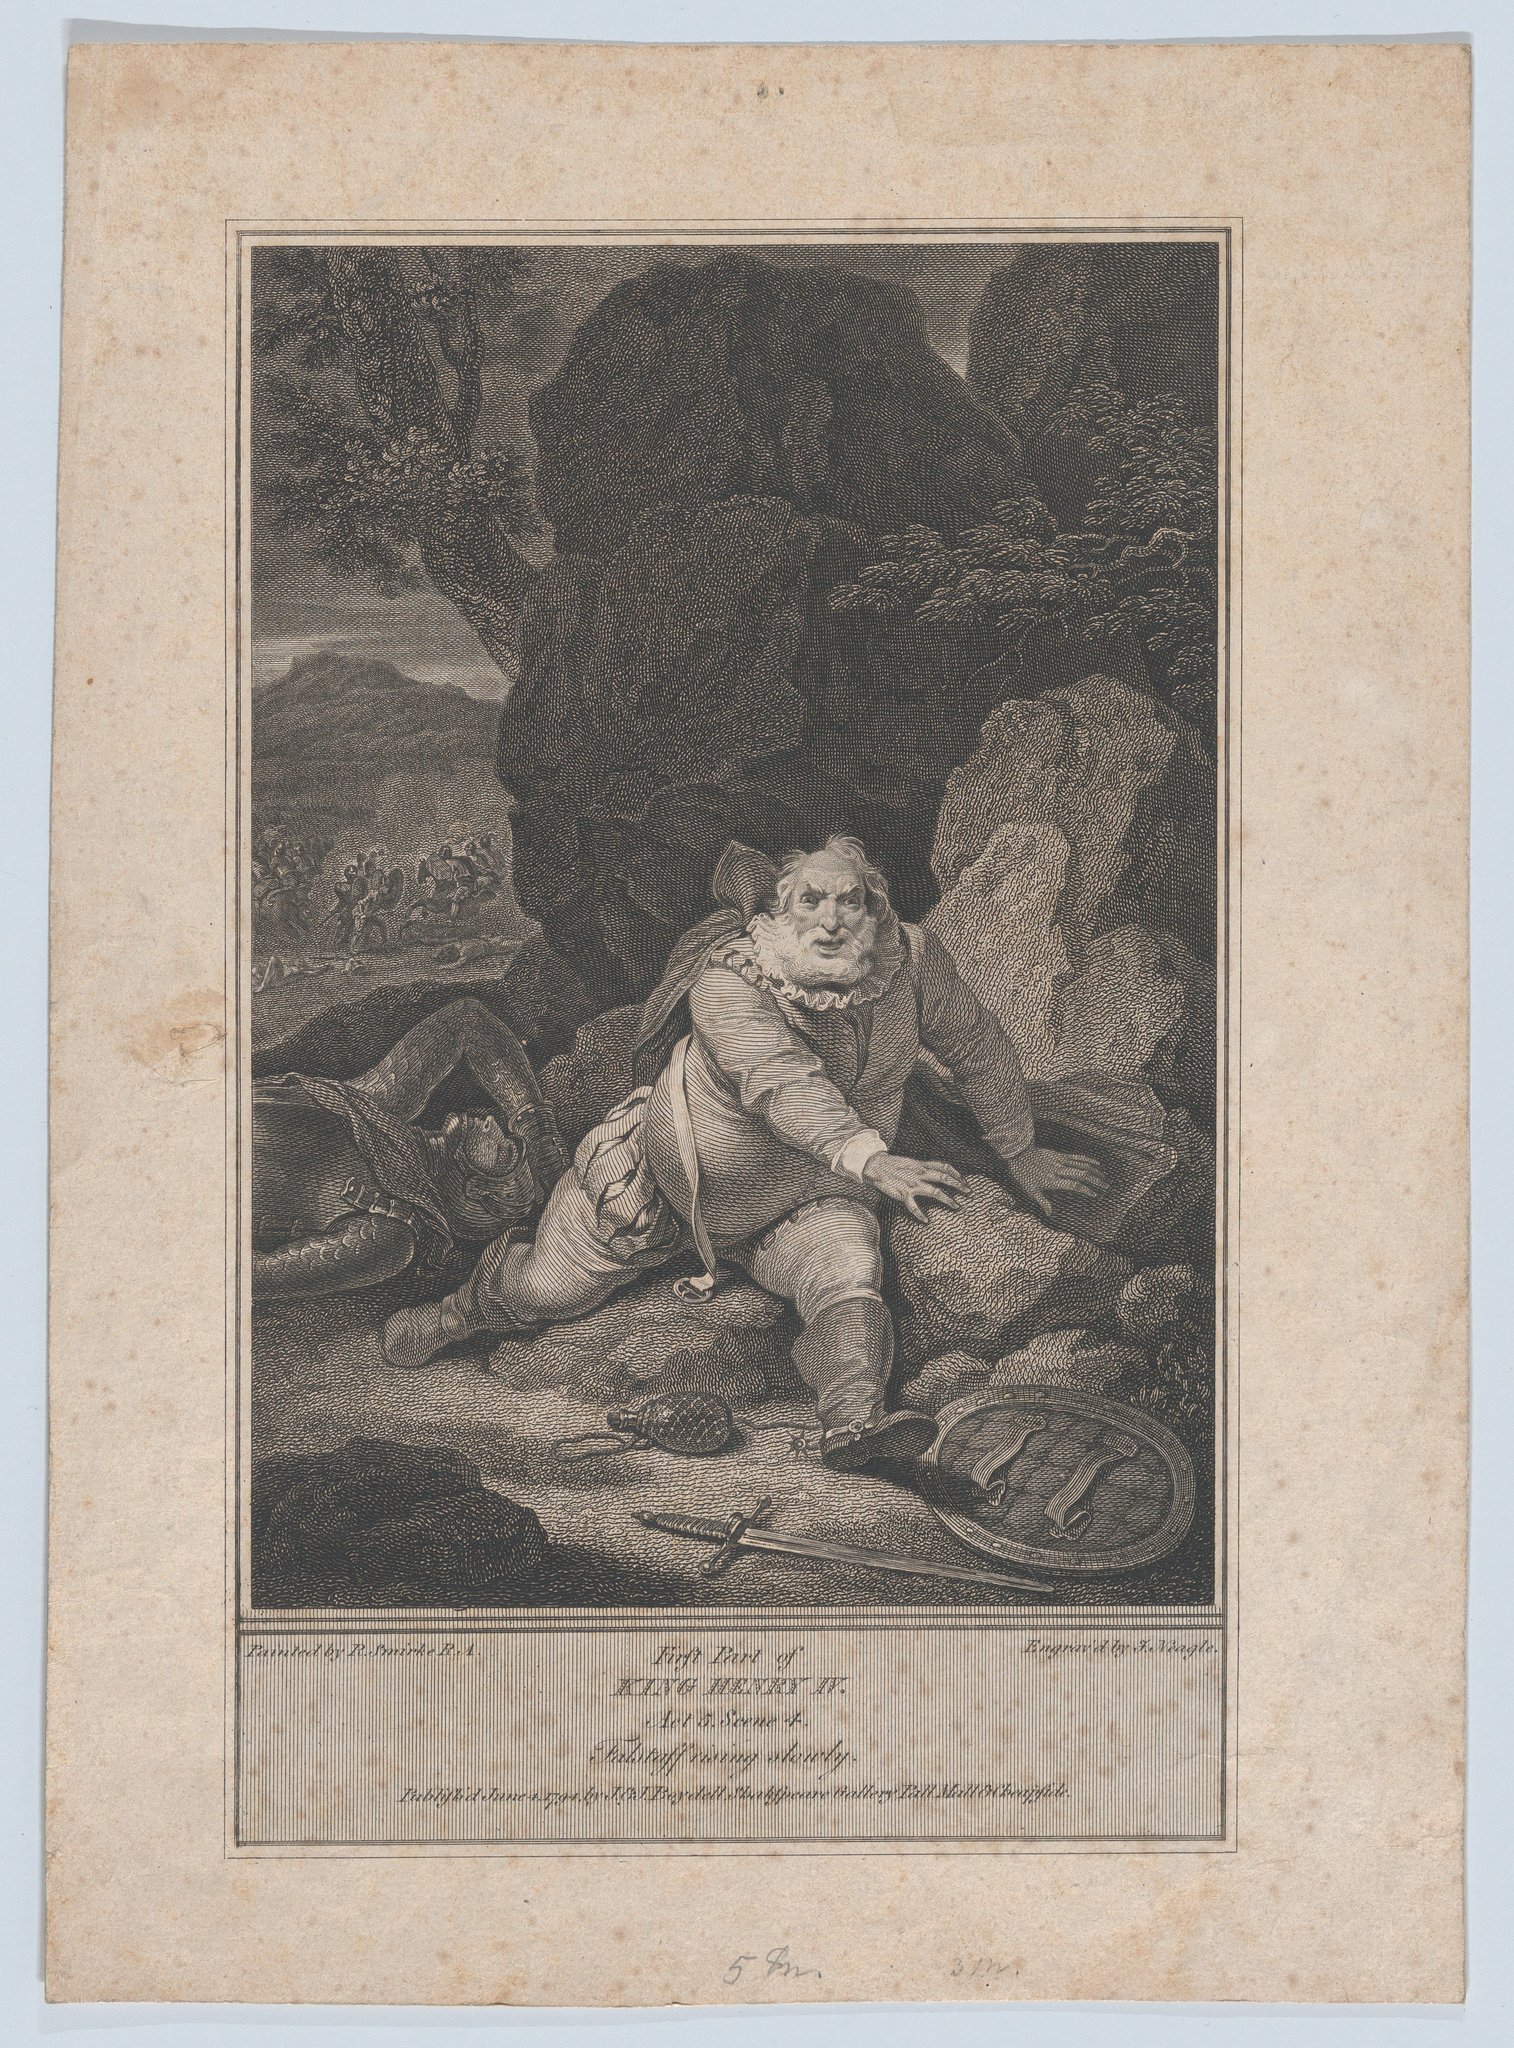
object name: print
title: Falstaff Rising Slowly (Shakespeare, First Part of King Henry IV, Act 5, Scene 4)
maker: james neagle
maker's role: engraver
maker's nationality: british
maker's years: 1765-1822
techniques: engraving, etching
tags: shakespeare,men